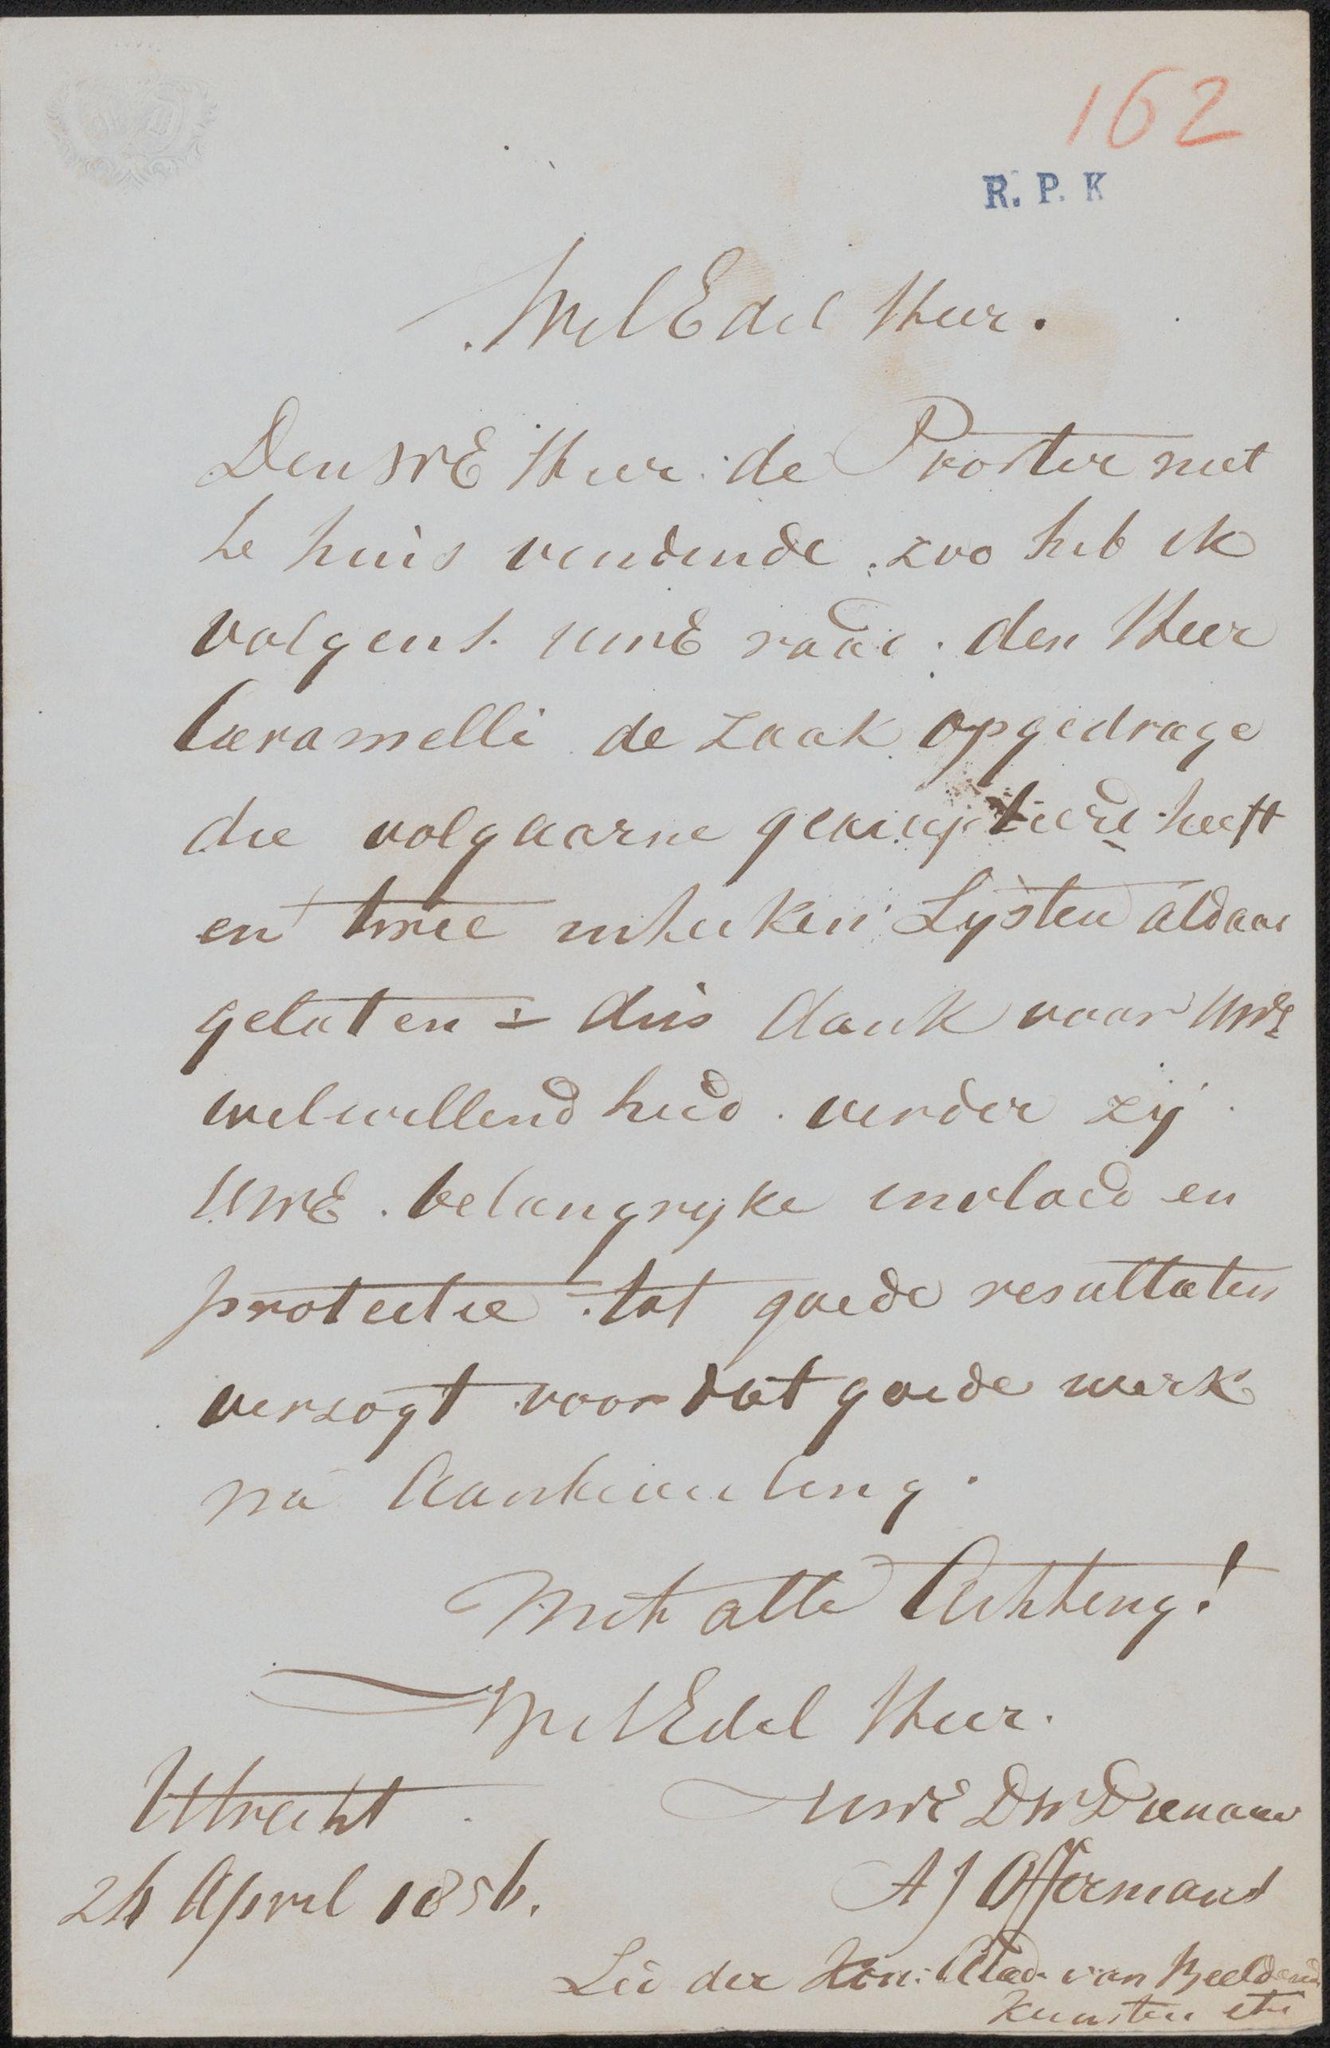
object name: letter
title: Brief aan anoniem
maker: anthony jacobus offermans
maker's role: draughtsman, print maker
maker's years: 1796-1872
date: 1856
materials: ink, paper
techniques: pen, writing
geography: utrecht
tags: utrecht, amsterdam, publisher, alberto caramelli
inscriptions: collector's mark: Lugt 2233